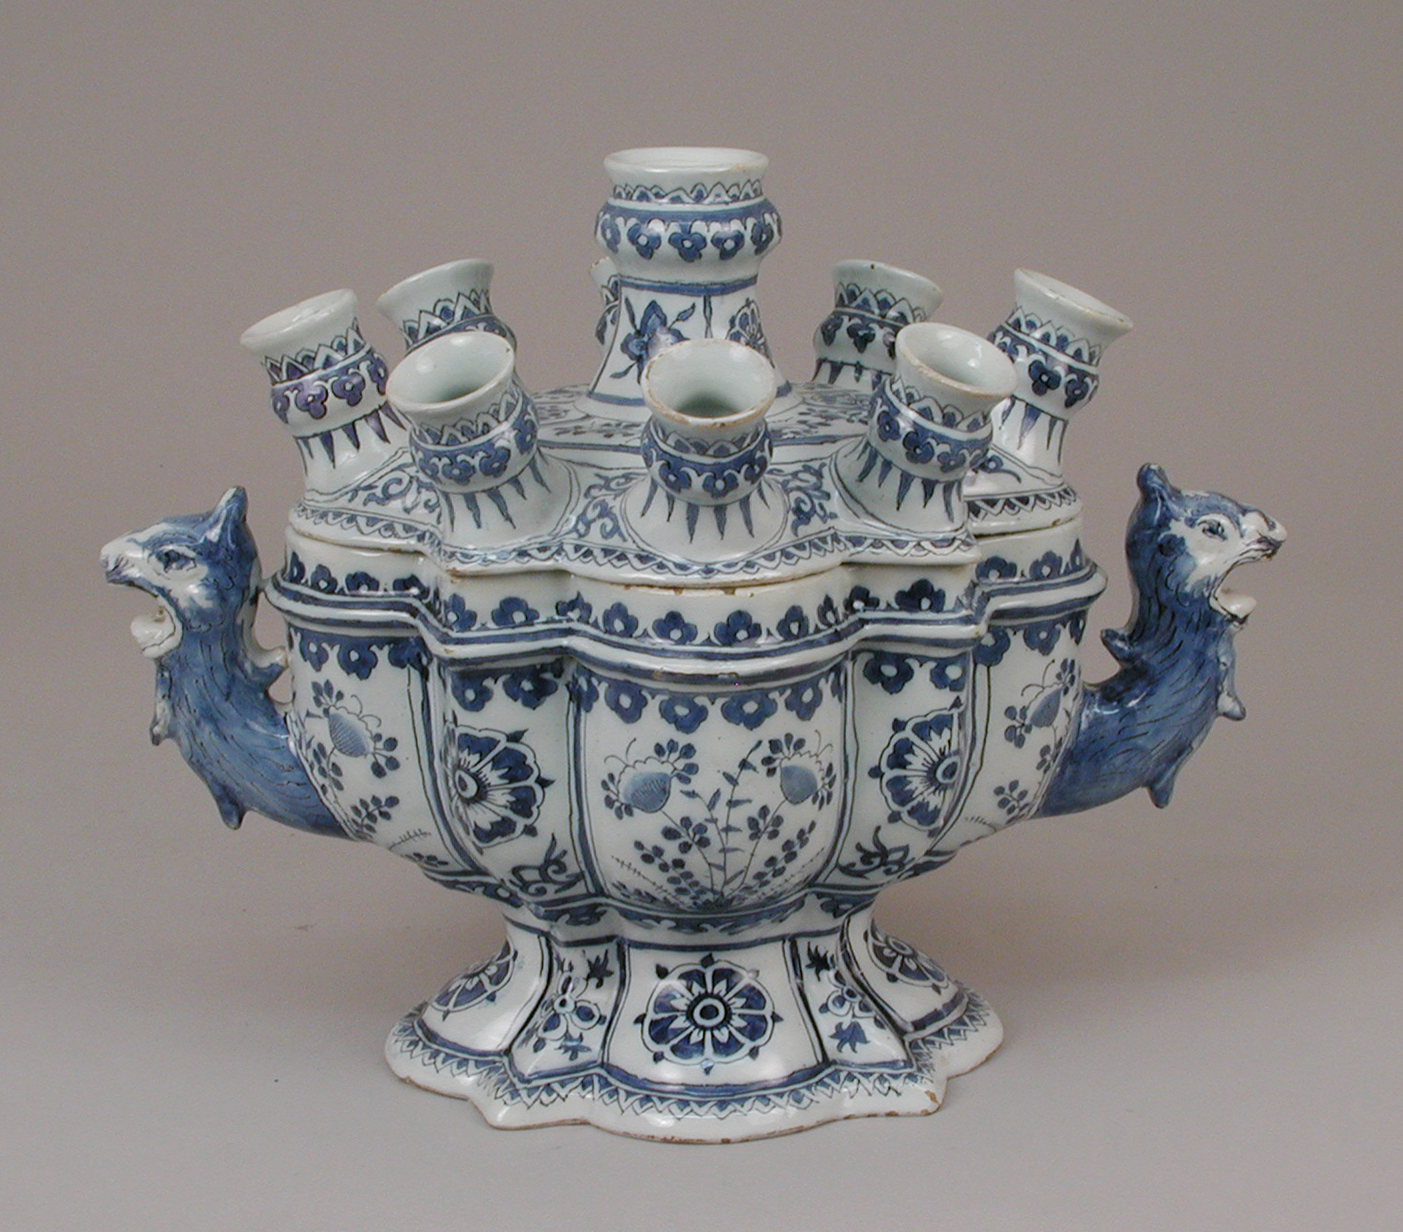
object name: flower vase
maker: the "greek a" factory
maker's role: factory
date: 1695-1705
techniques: glazing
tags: flowers